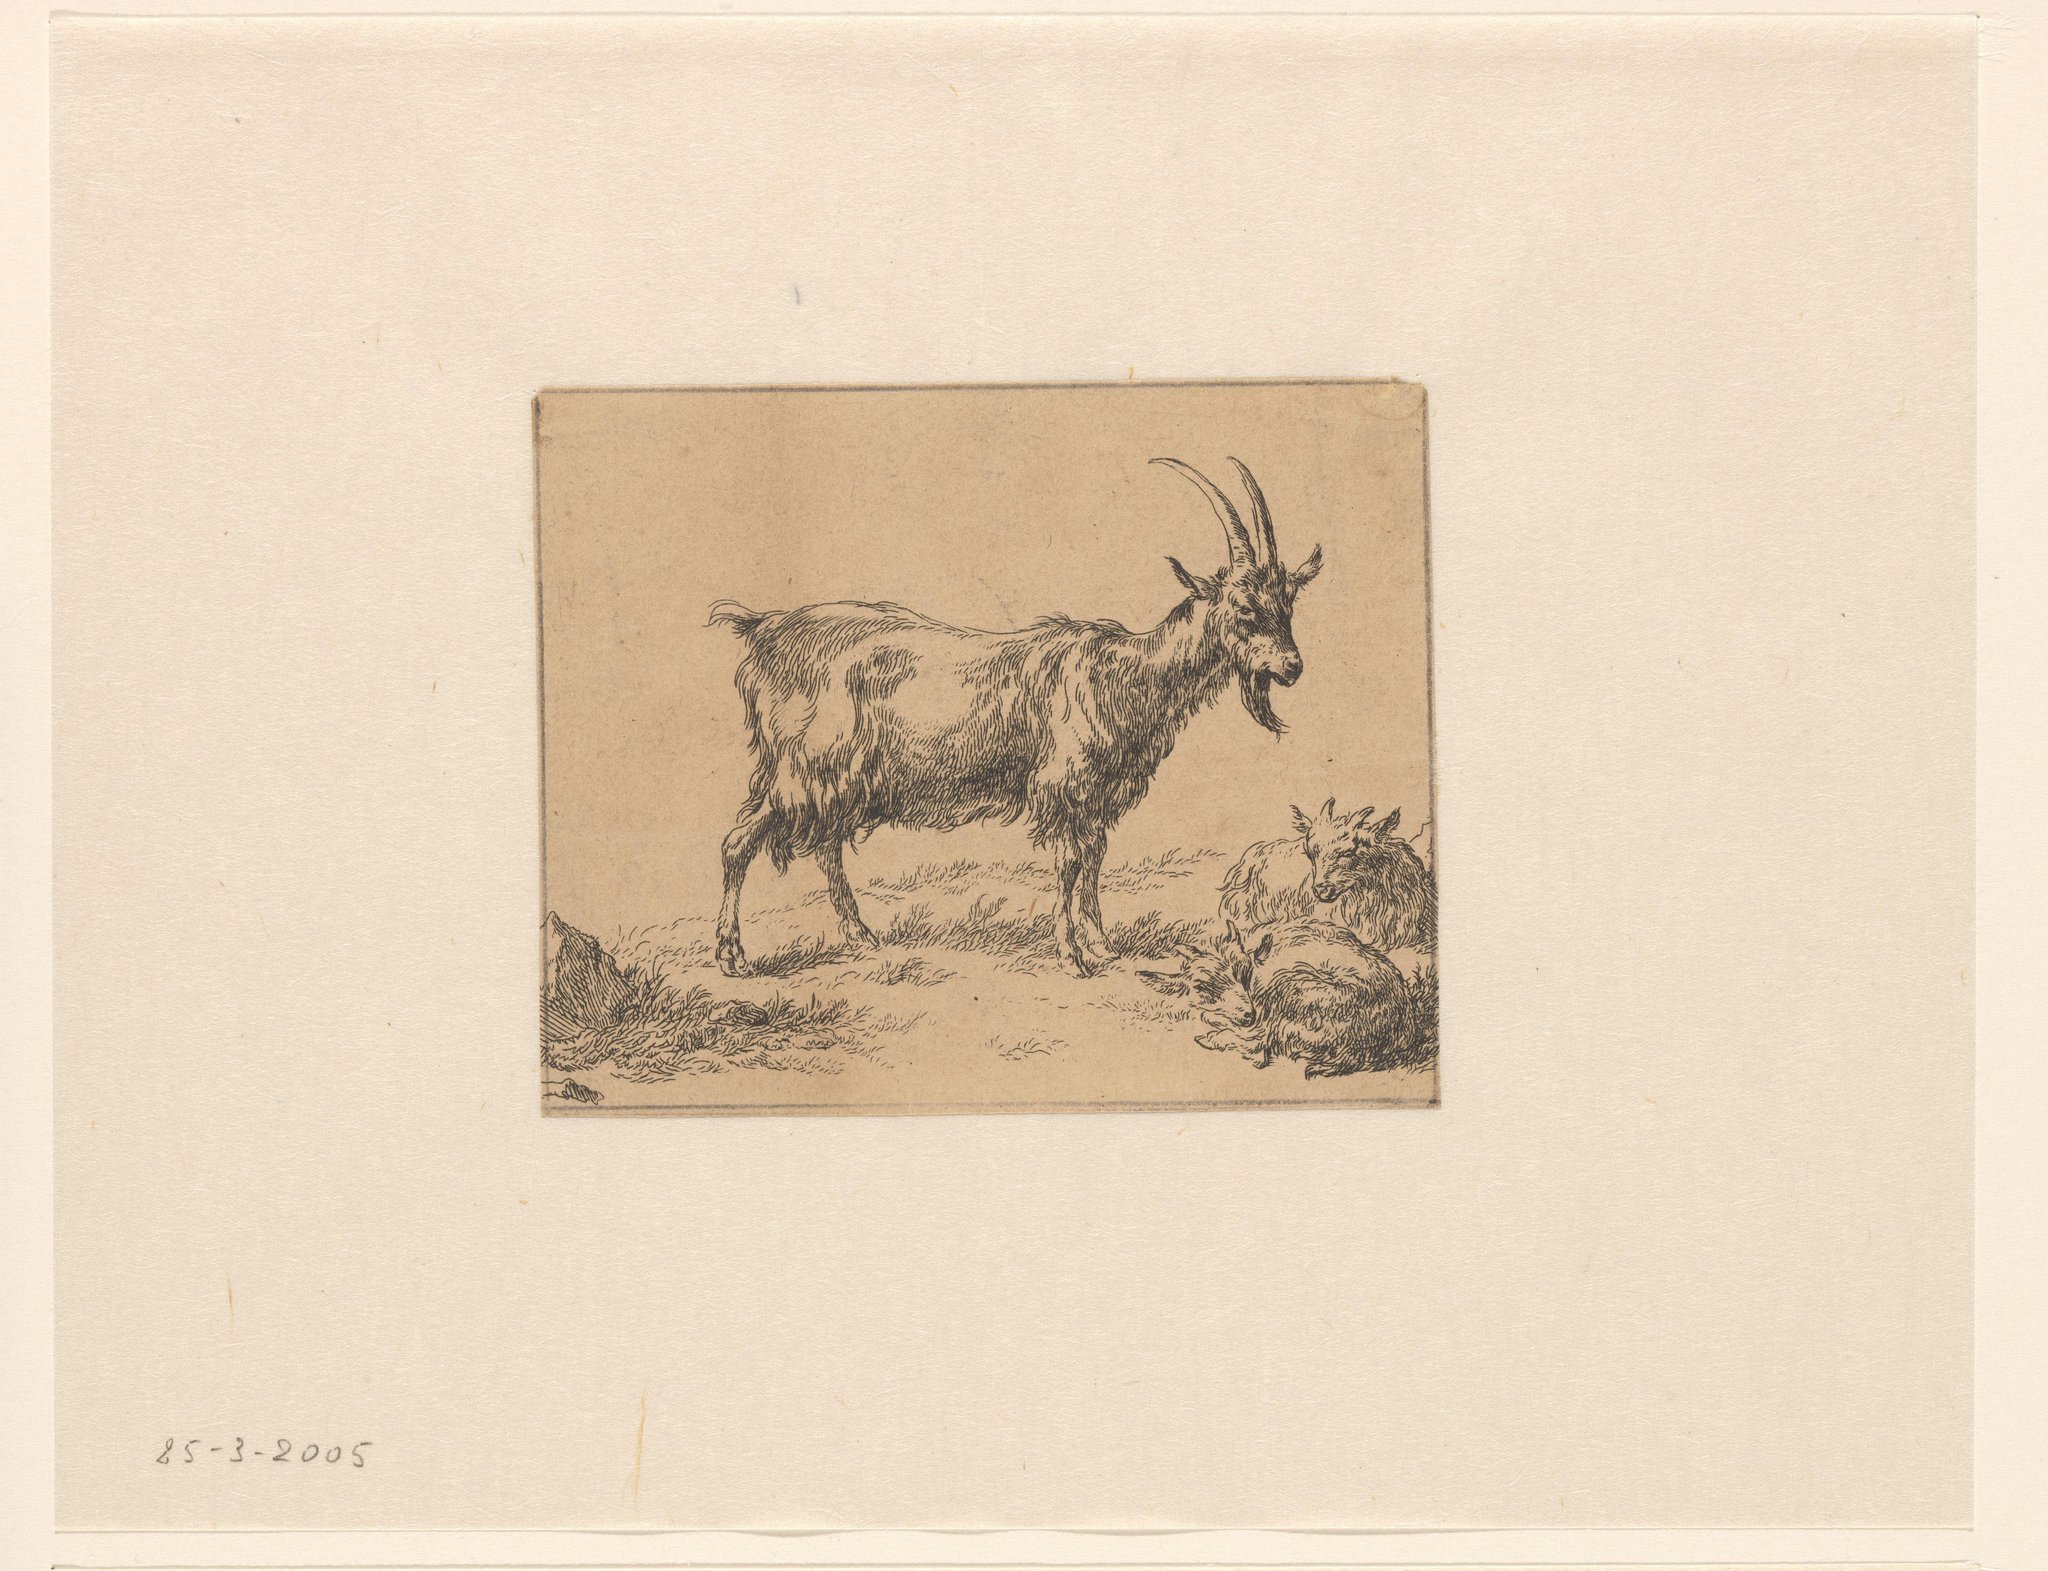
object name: print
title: Staande geit met twee bokjes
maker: nicolaes pietersz berchem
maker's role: draughtsman, print maker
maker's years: 1620-1683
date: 1631-1683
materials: paper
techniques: etching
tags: goat